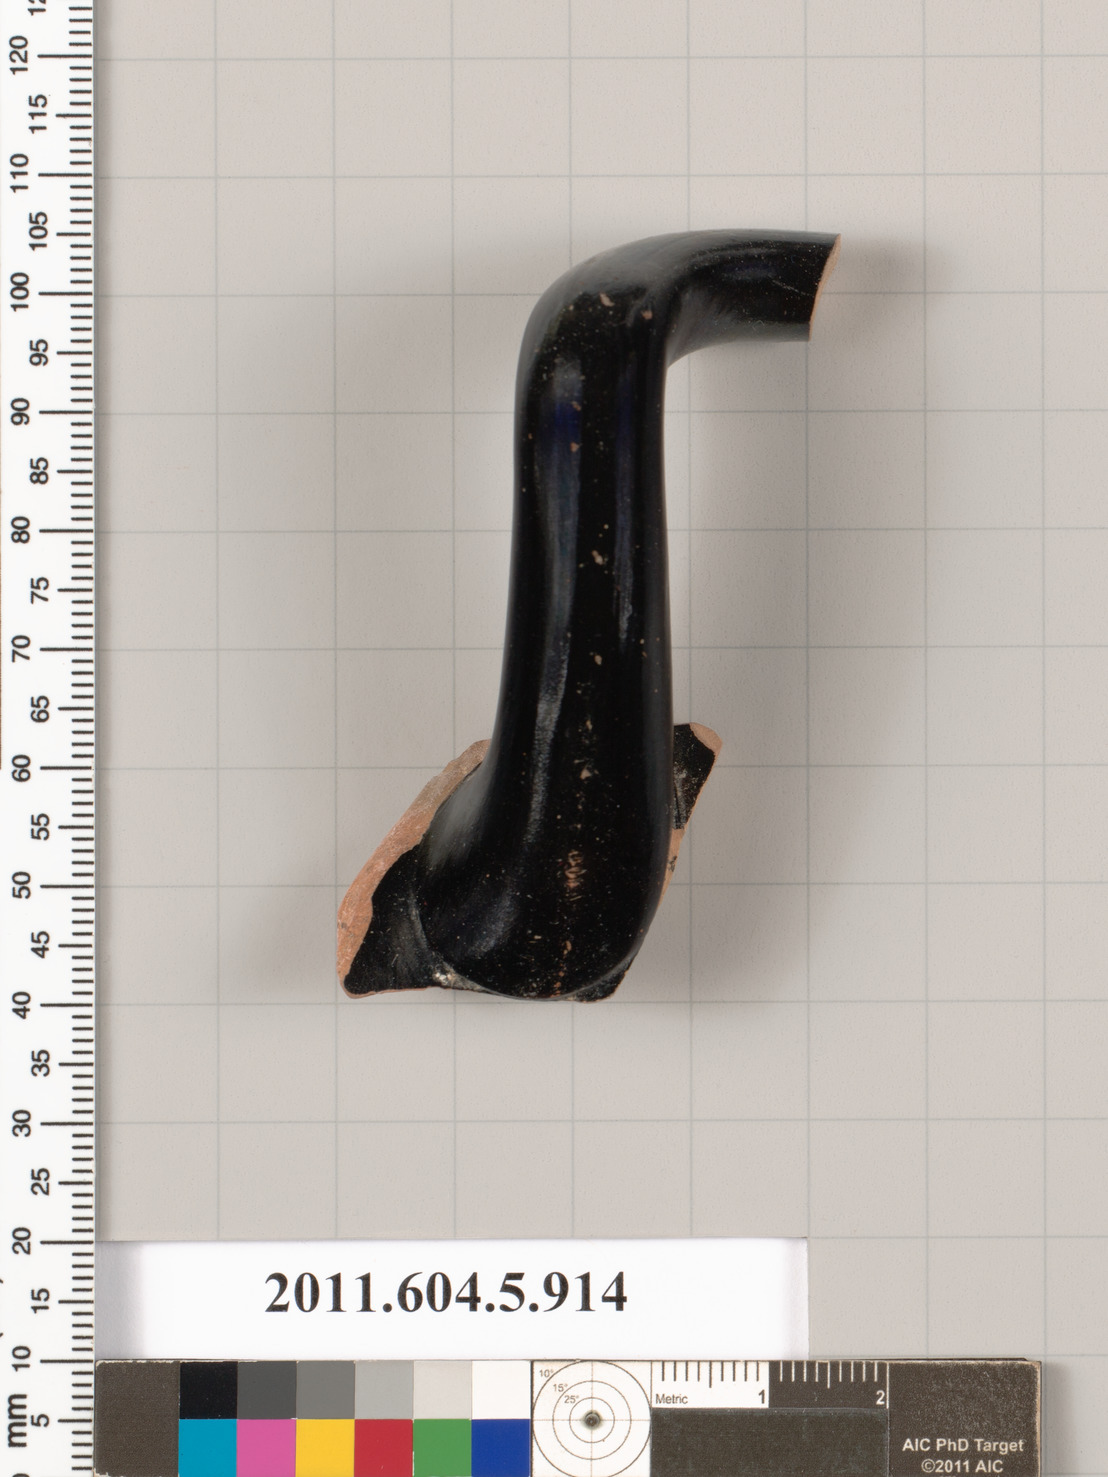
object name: kylix fragment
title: Terracotta fragment of a kylix (drinking cup)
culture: greek, attic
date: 600-401 BCE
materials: terracotta